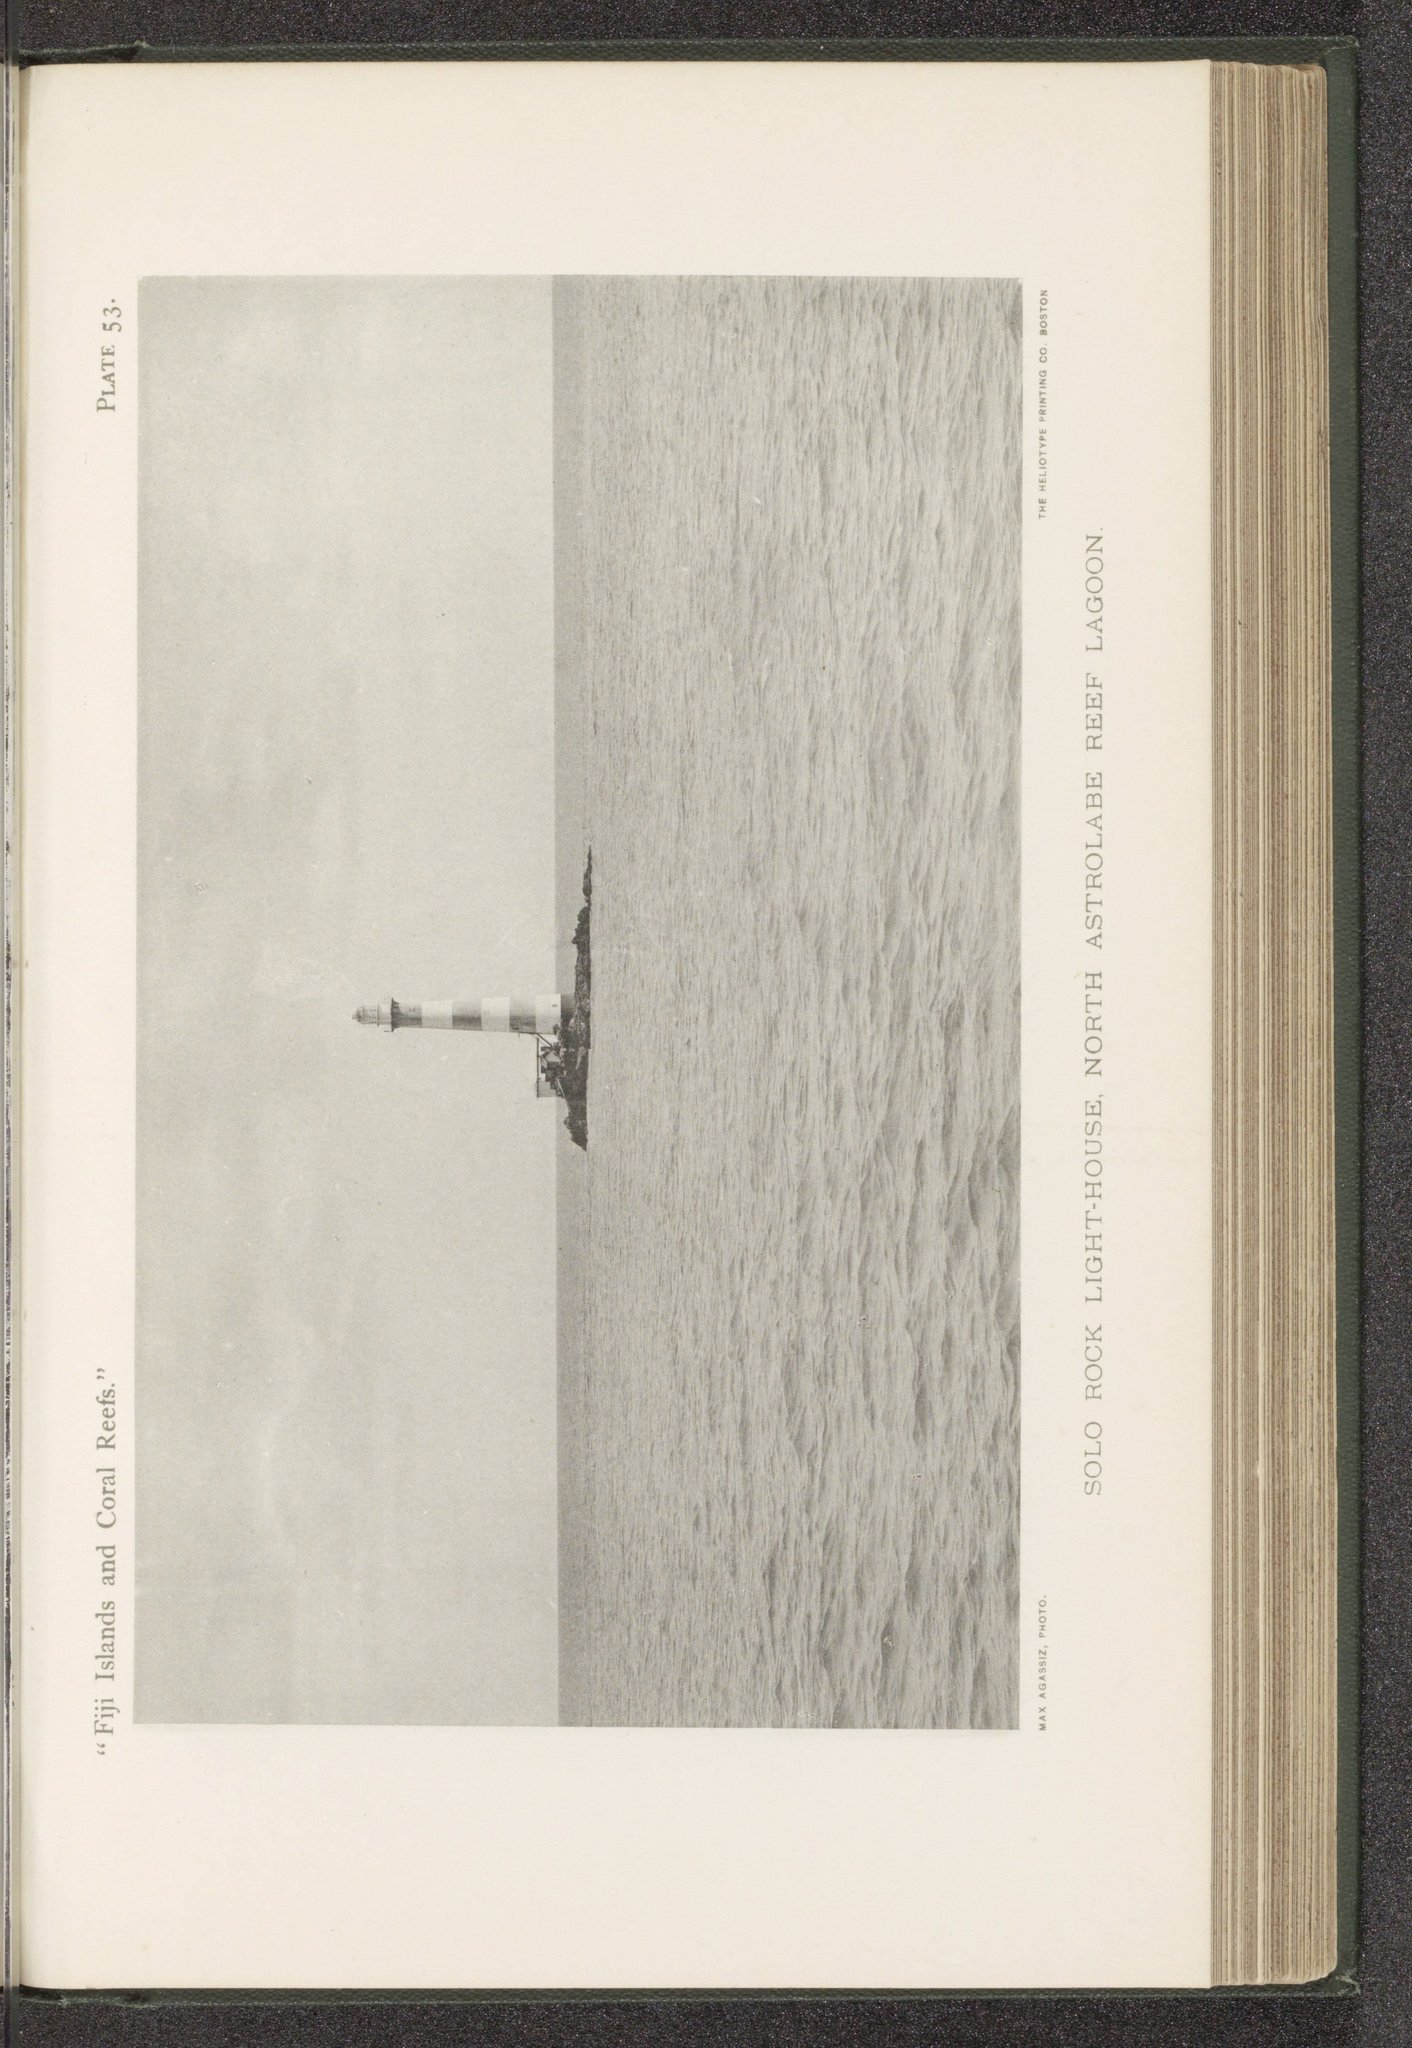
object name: photomechanical print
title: Solo Rock light-house, north Astrolabe reef lagoon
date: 1885-1899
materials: paper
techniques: photograph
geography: fiji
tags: lighthouse, lightship, coral reef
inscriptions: number: ‘Plate 53.’, name: ‘Max Agassiz, Photo.’, name: ‘The Heliotype Printing Co. Boston’